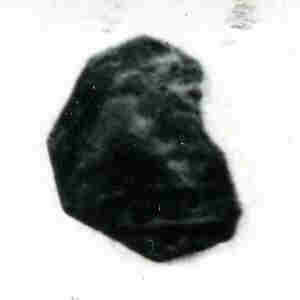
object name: coin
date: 701-900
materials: copper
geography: iran